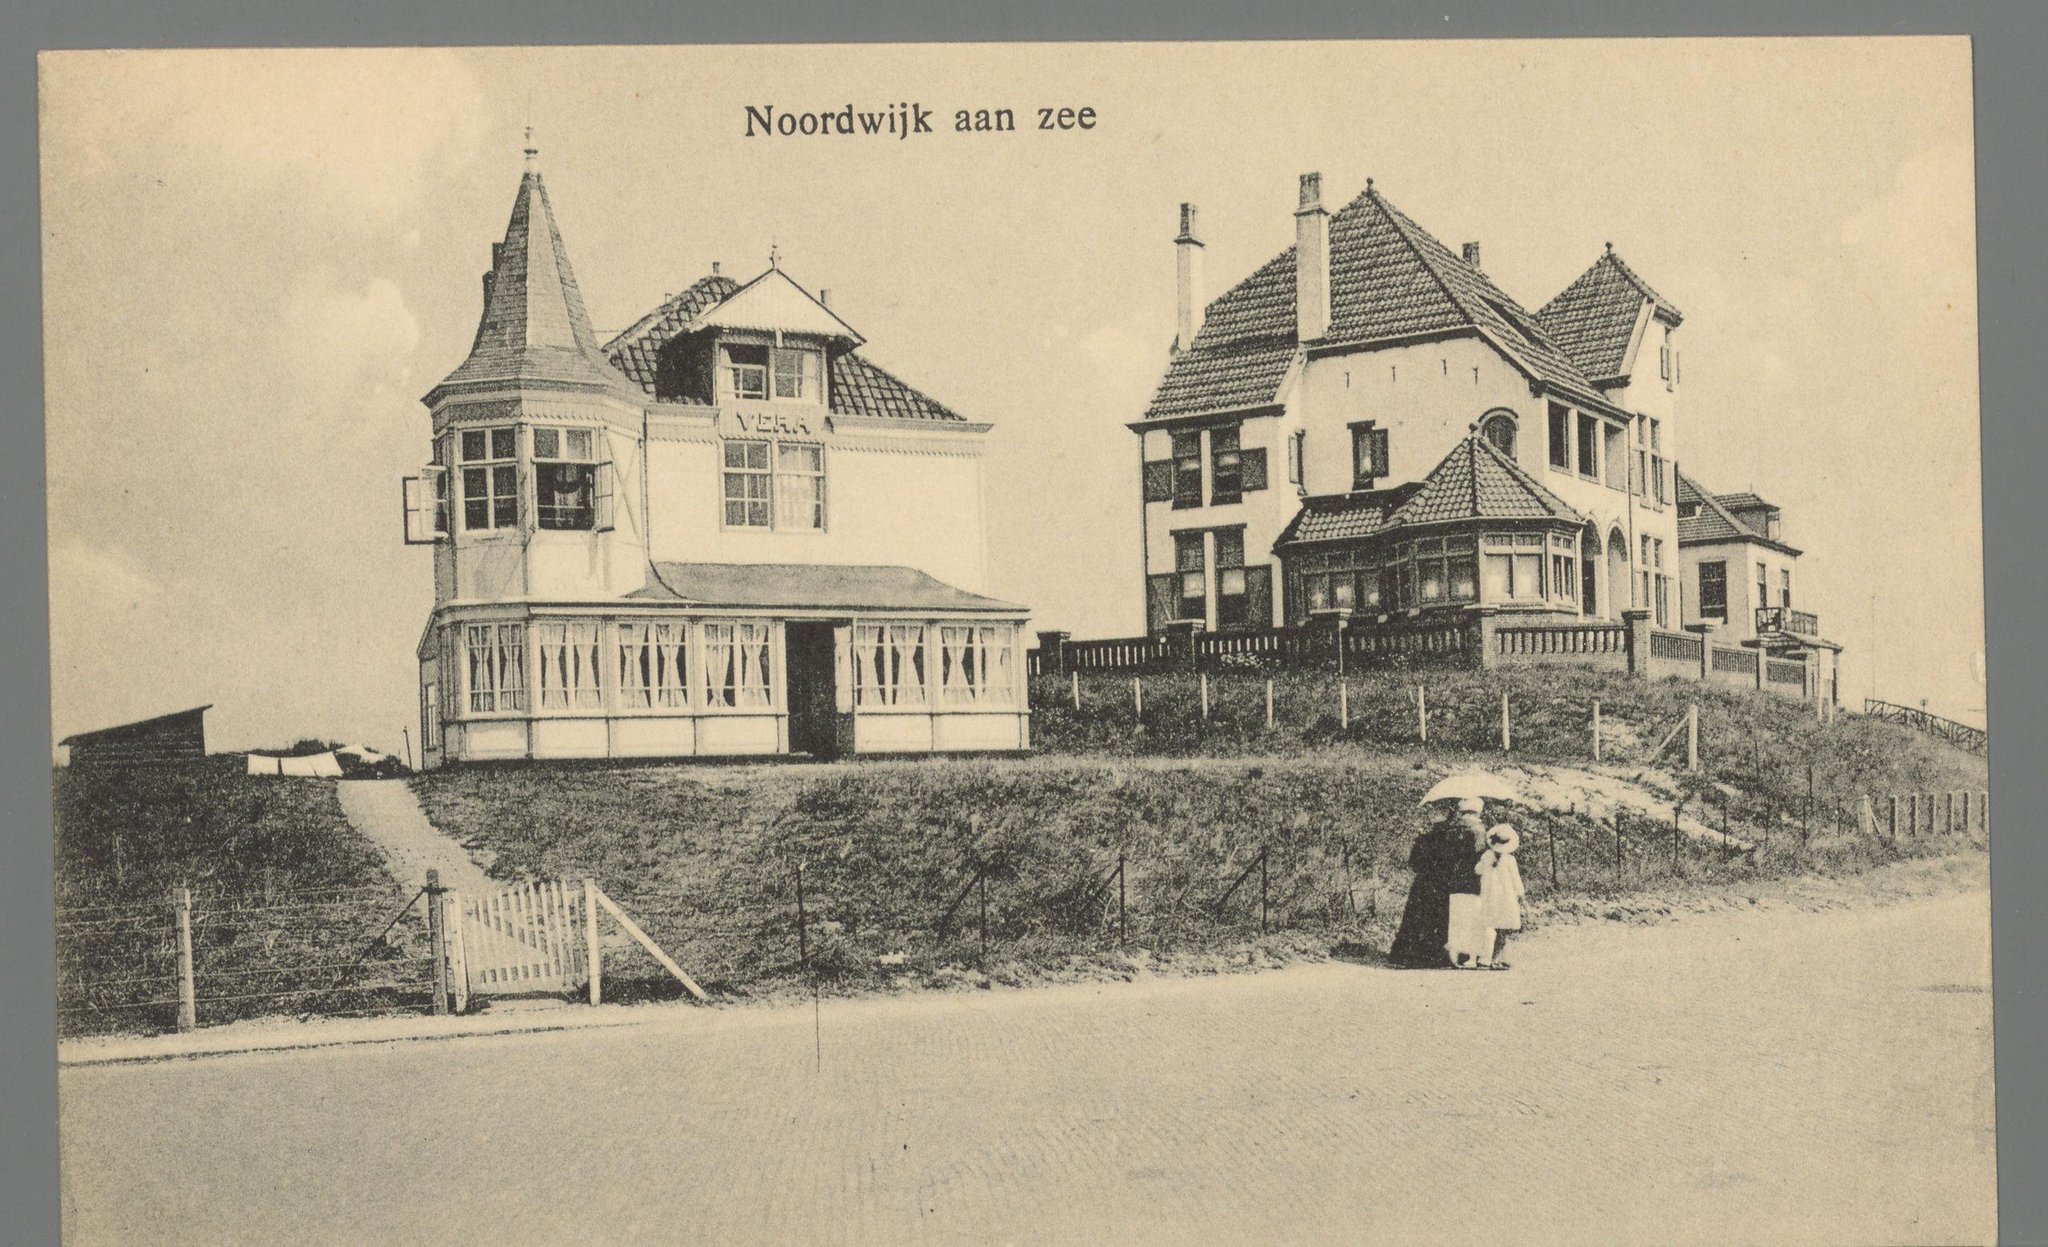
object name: photomechanical print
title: Noordwijk aan Zee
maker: Anonymous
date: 1905-1930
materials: cardboard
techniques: photograph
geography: noordwijk aan zee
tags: dunes (sea not visible); in the dunes